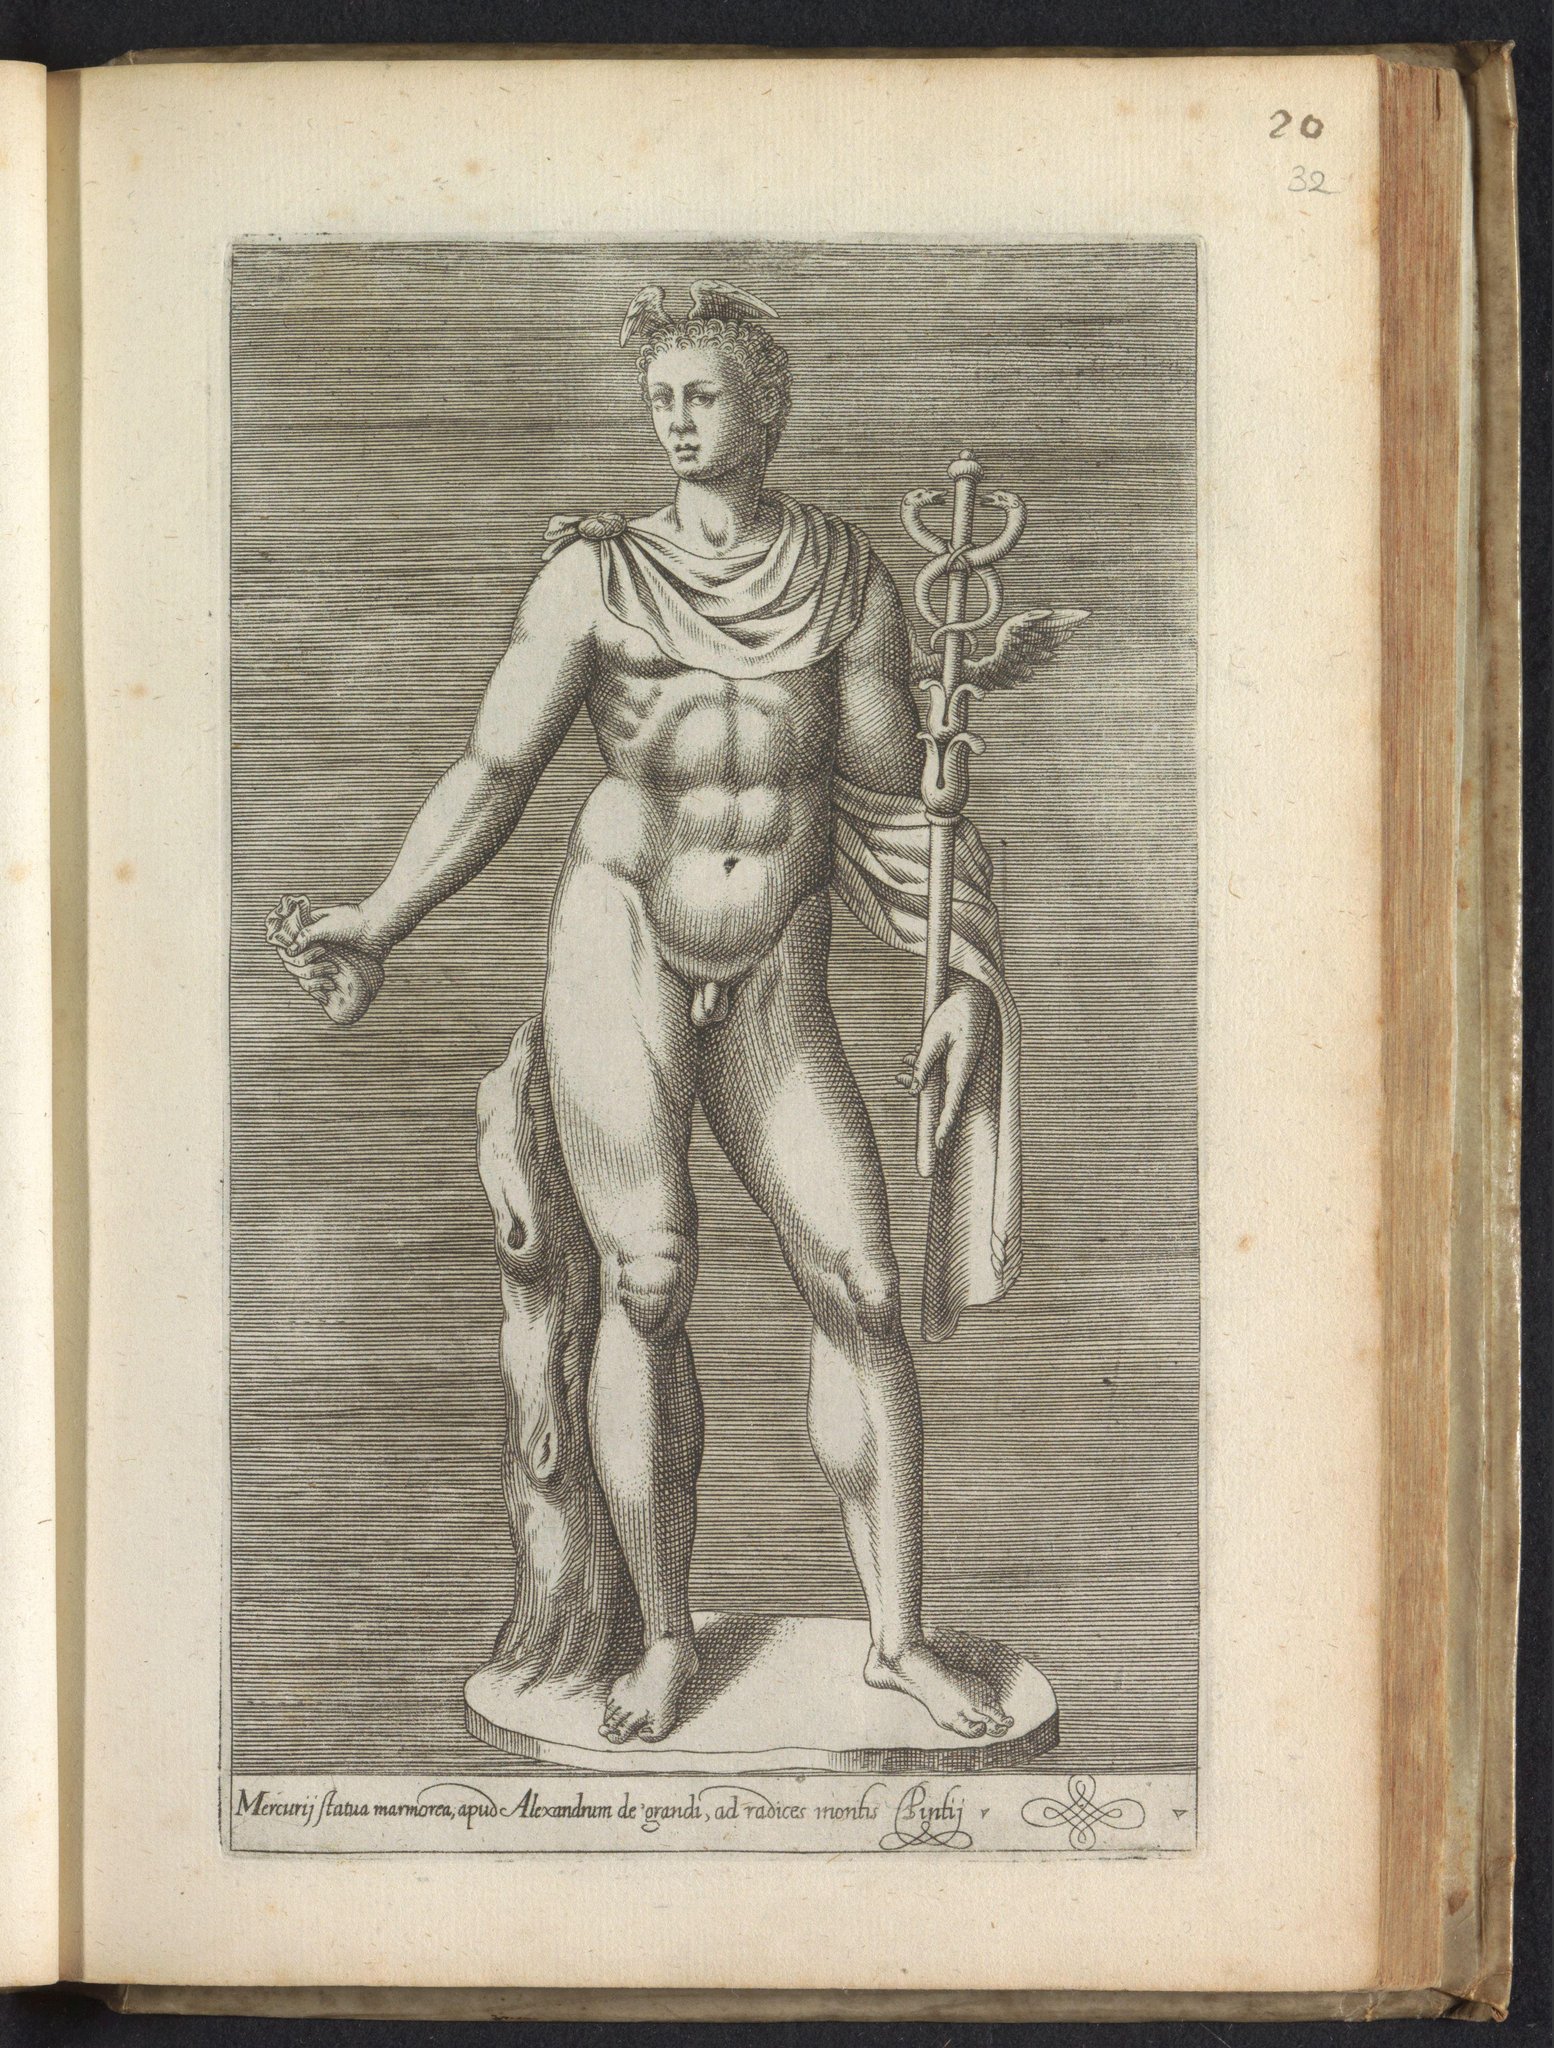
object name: album leaf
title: Mercurij statua marmorea, apud Alexandrum de grand (...)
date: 1584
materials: paper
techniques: engraving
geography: italy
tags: (story of) mercury (hermes), piece of sculpture, reproduction of a piece of sculpture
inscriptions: number: ‘20’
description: Deze prent maakt deel uit van een set van 79 prenten (+ titelprent) met voorstellingen van antieke sculpturen in Rome.